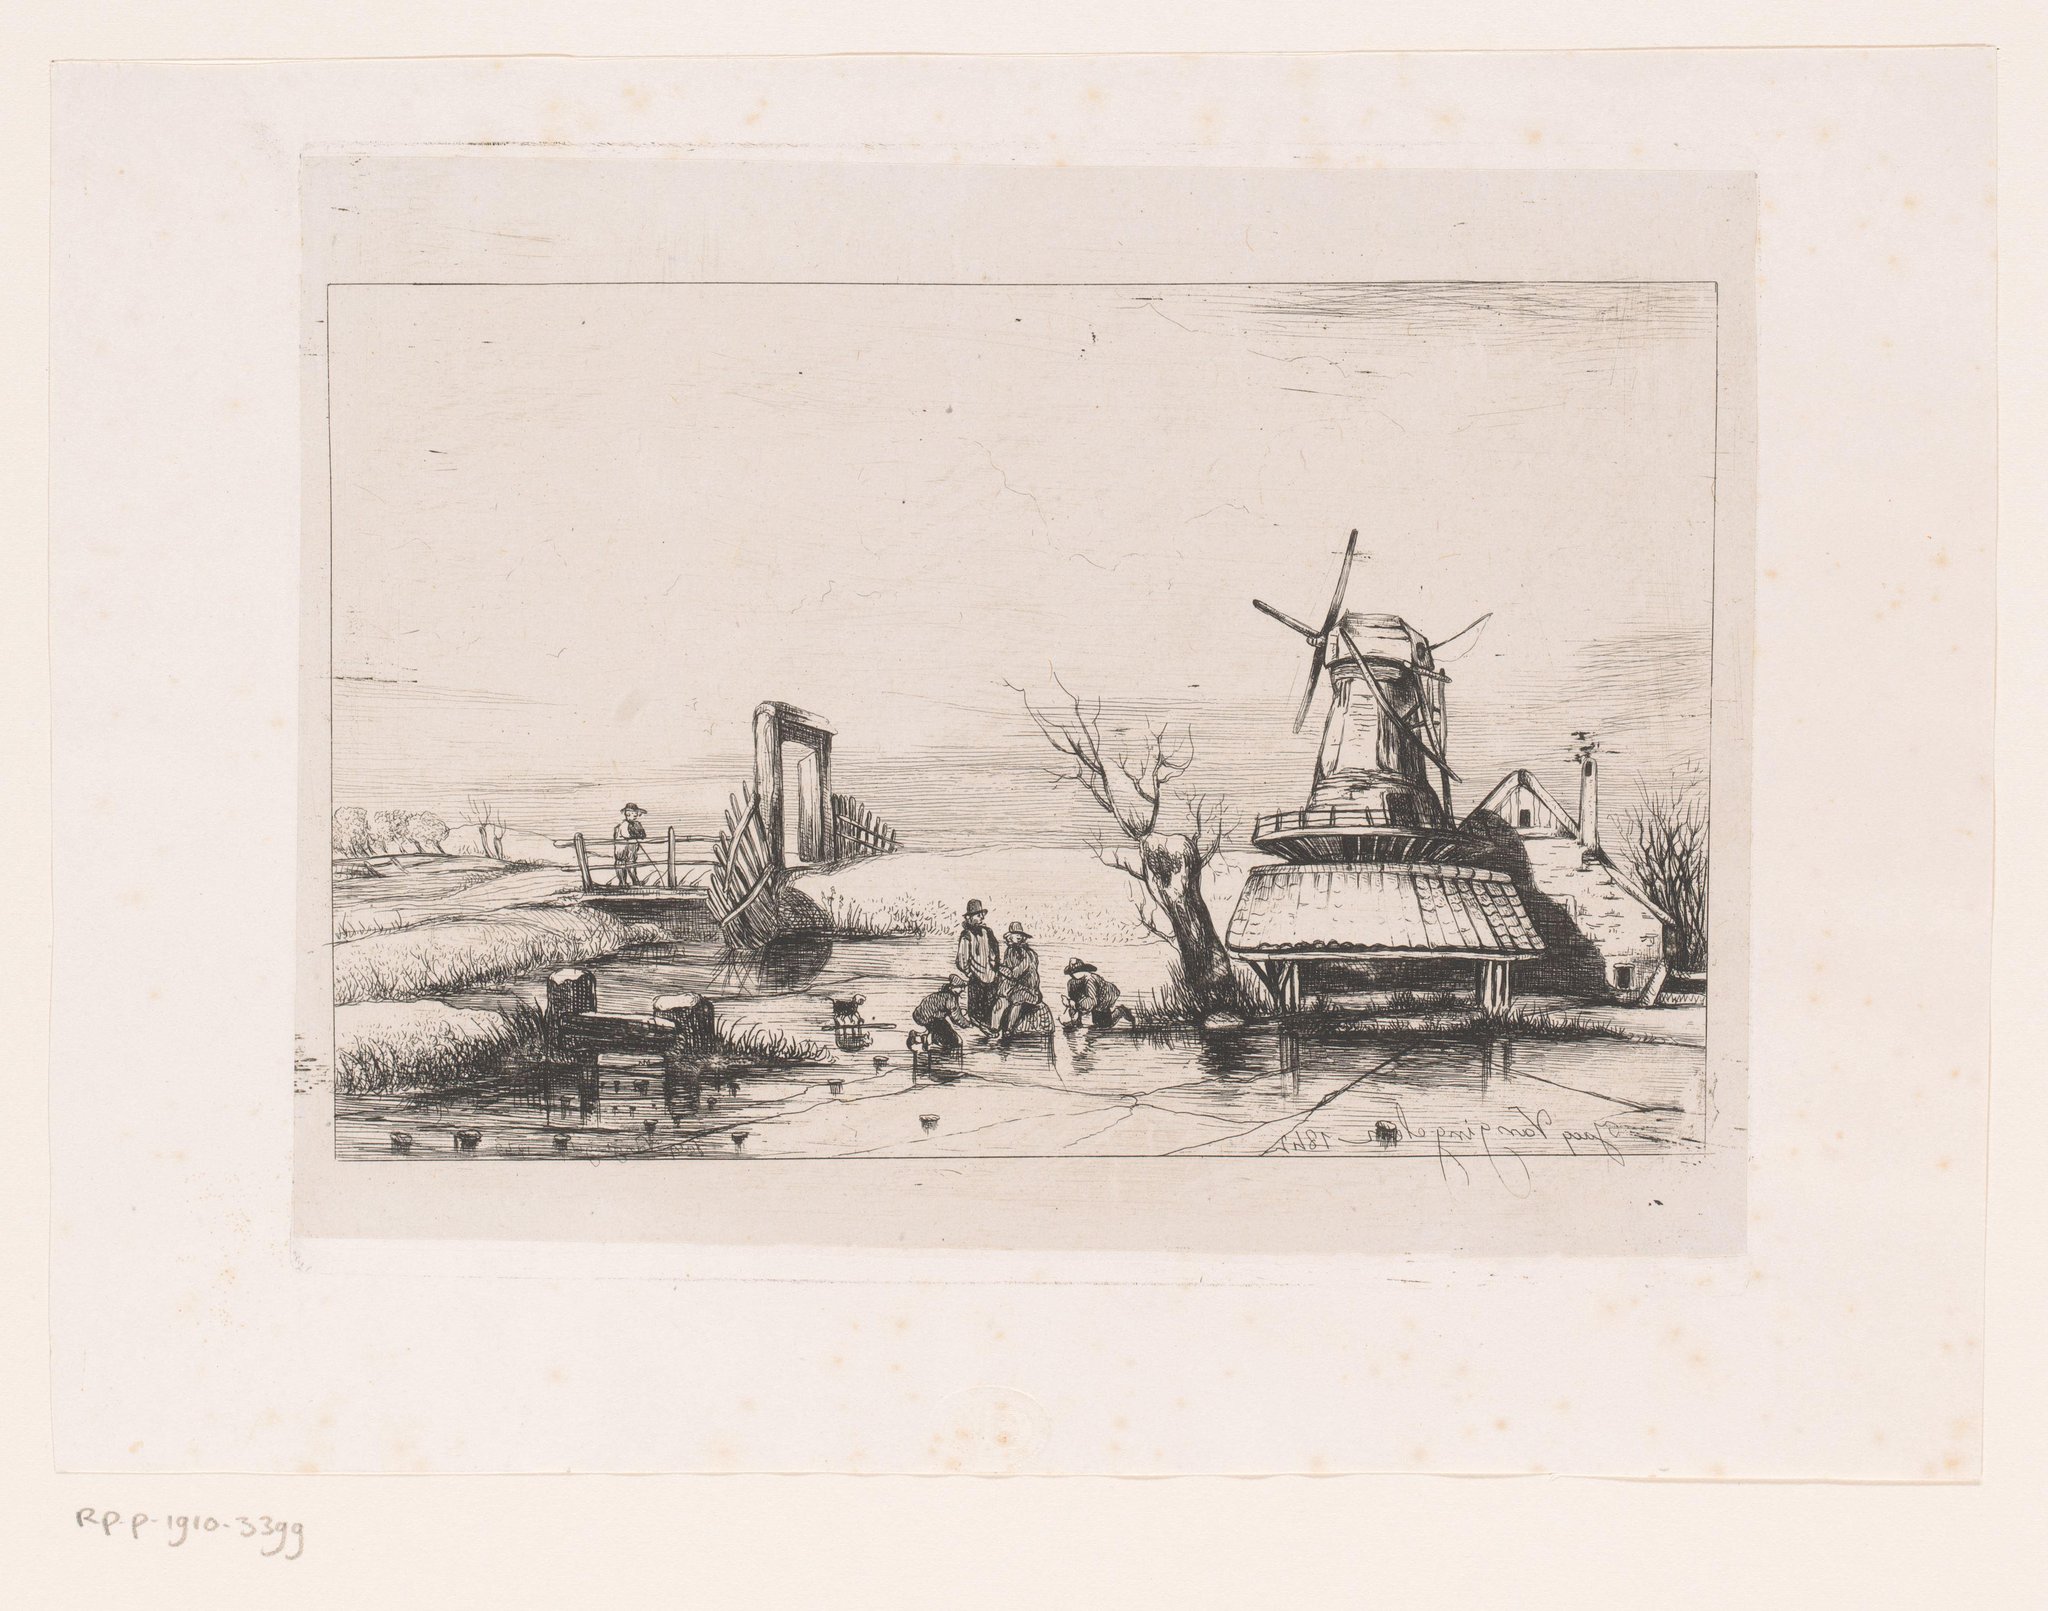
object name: print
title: Landschap met schaatsers op het ijs rondom een molen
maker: jacques van gingelen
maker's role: print maker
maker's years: 1801-1864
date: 1842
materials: paper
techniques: etching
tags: windmill in landscape, skates (winter sports)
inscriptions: mark: ‘JVG’, collector's mark: Lugt 2228